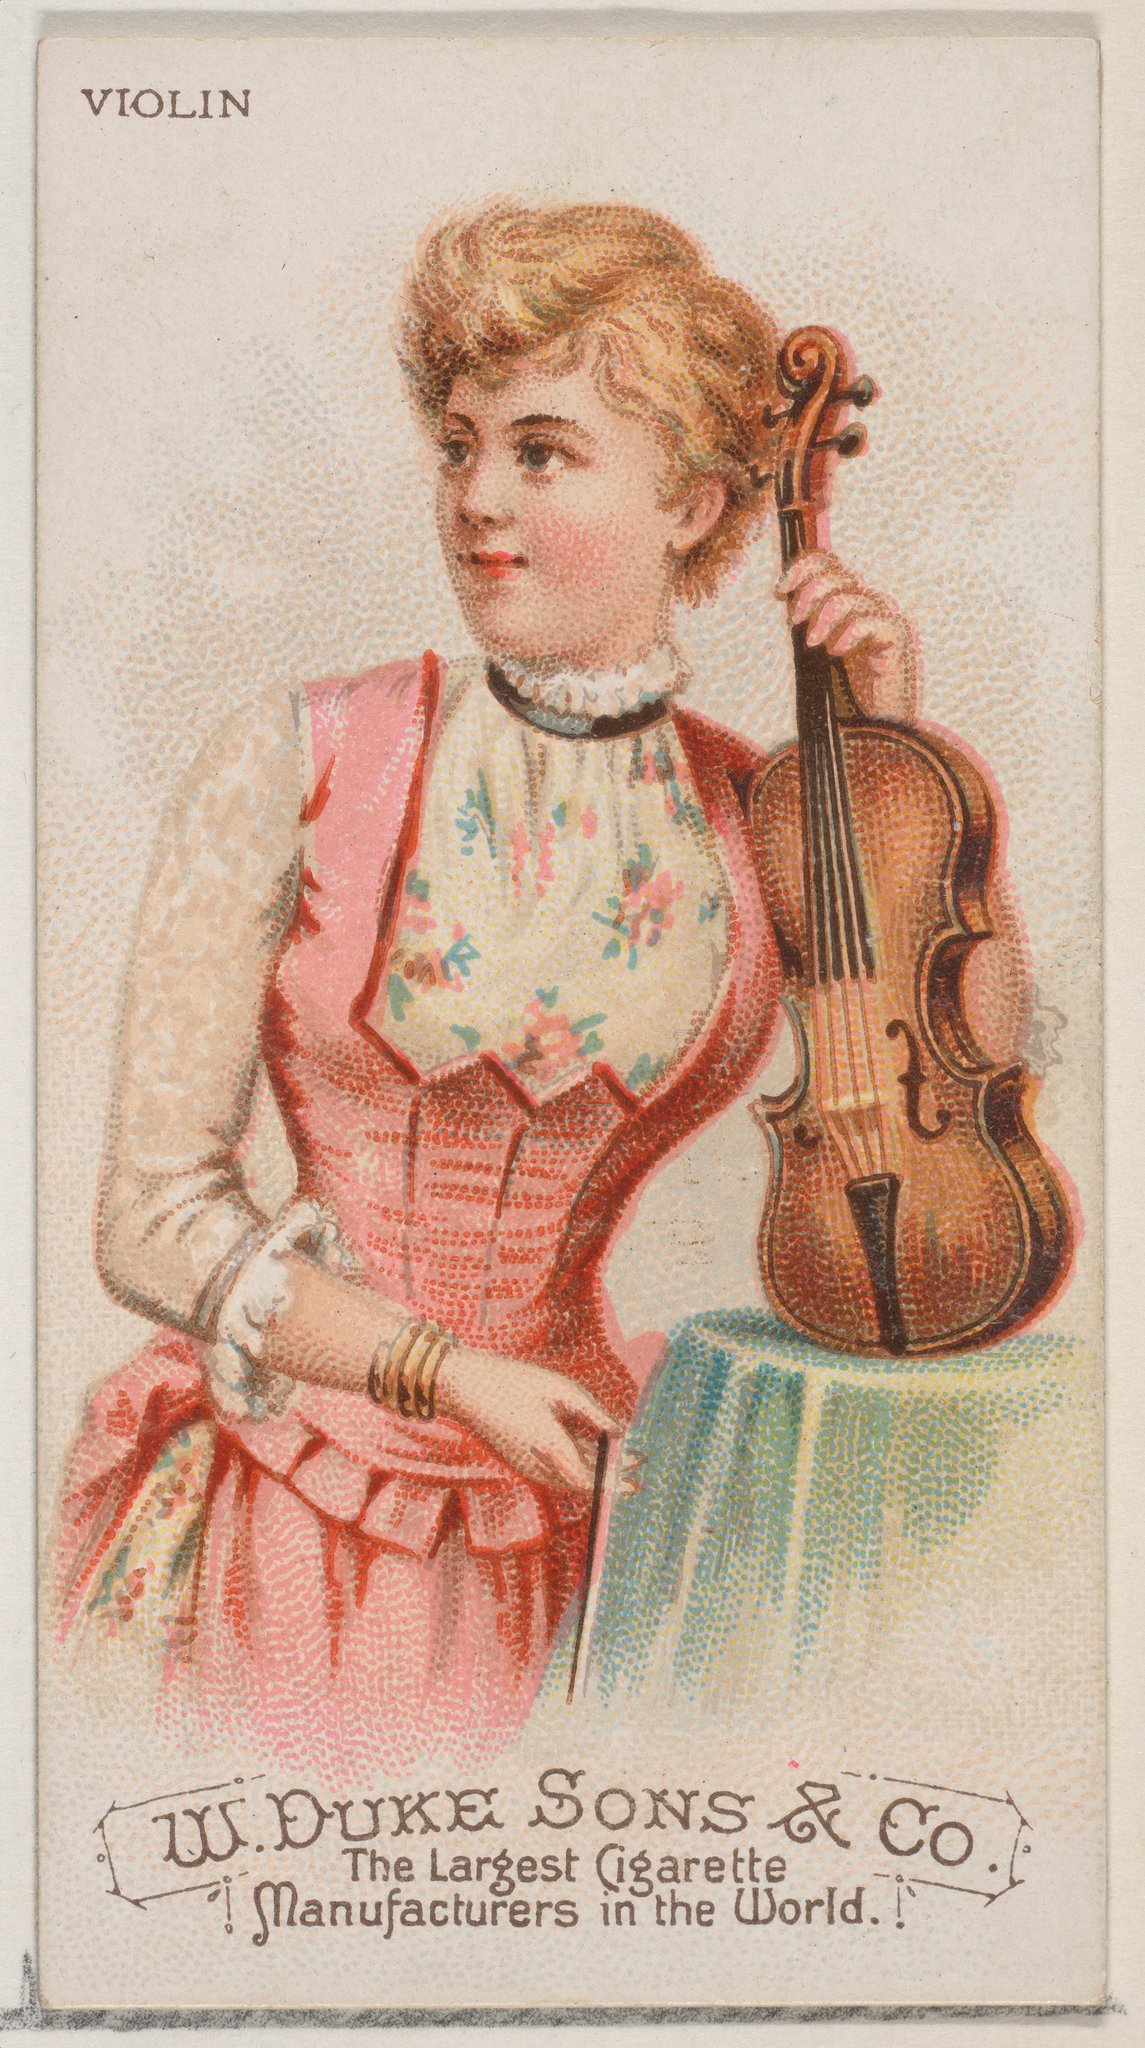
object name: print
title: Violin, from the Musical Instruments series (N82) for Duke brand cigarettes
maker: w. duke, sons & co.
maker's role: publisher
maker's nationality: american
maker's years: 1870-1920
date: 1888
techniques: color lithograph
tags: women,violins,musicians